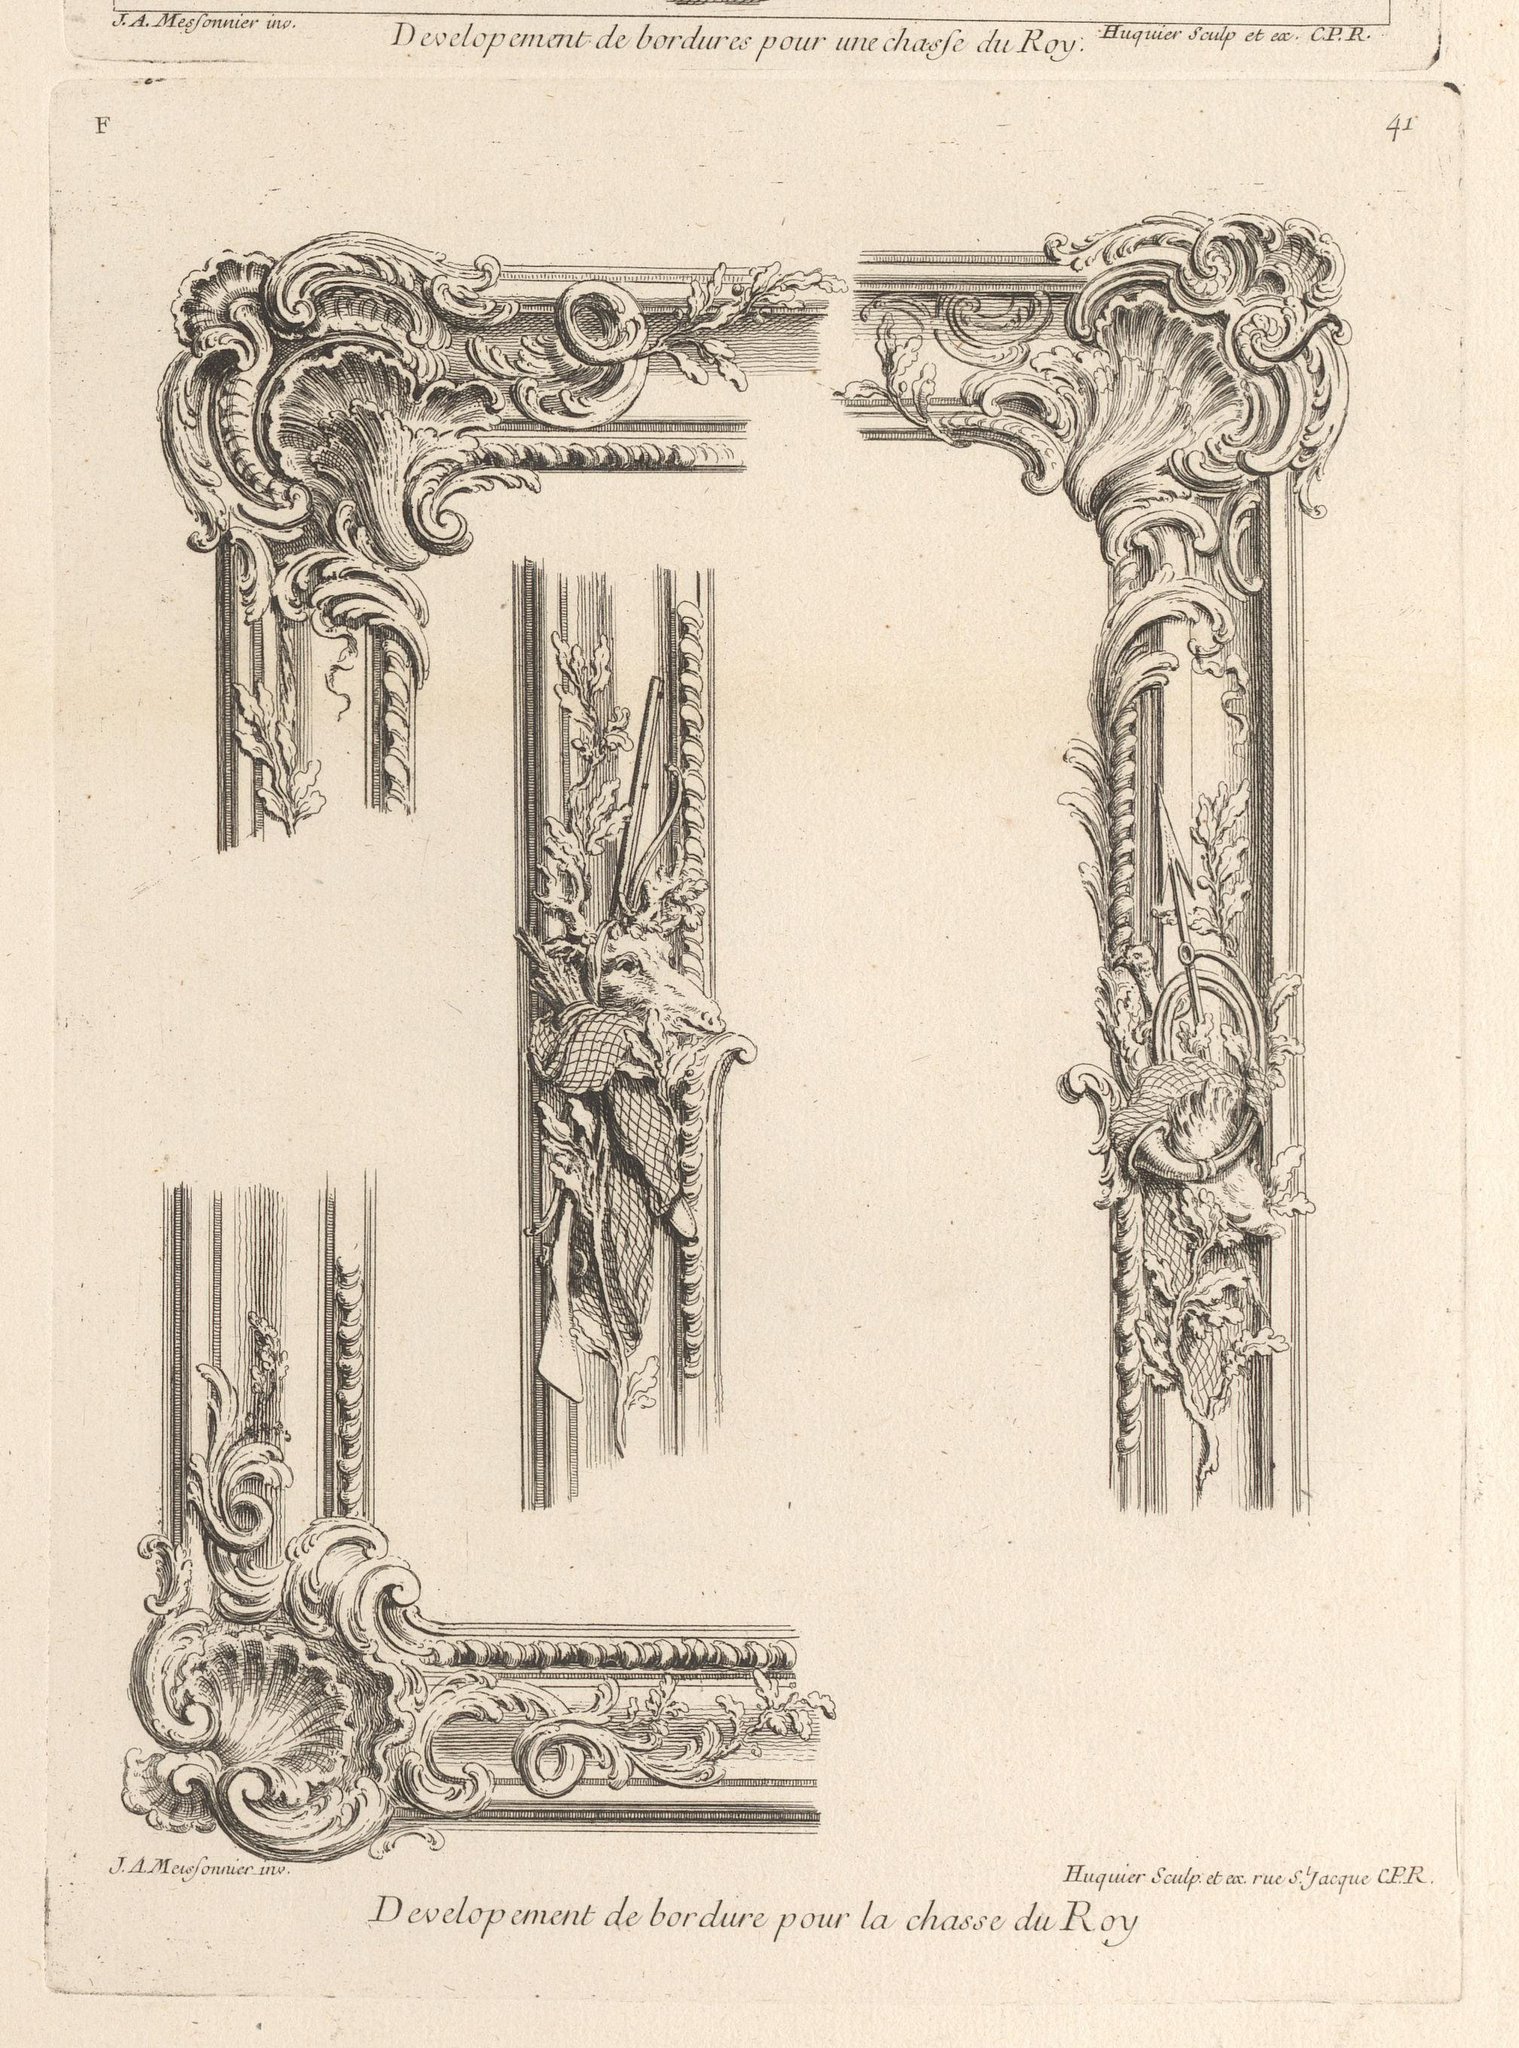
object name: album leaf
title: Developement de bordure pour la chasse du roy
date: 1738-1749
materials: paper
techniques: etching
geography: paris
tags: rocaille ornament, ornament derived from animal forms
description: Zevende (en laatste) prent uit een serie met soortgelijke voorstellingen.